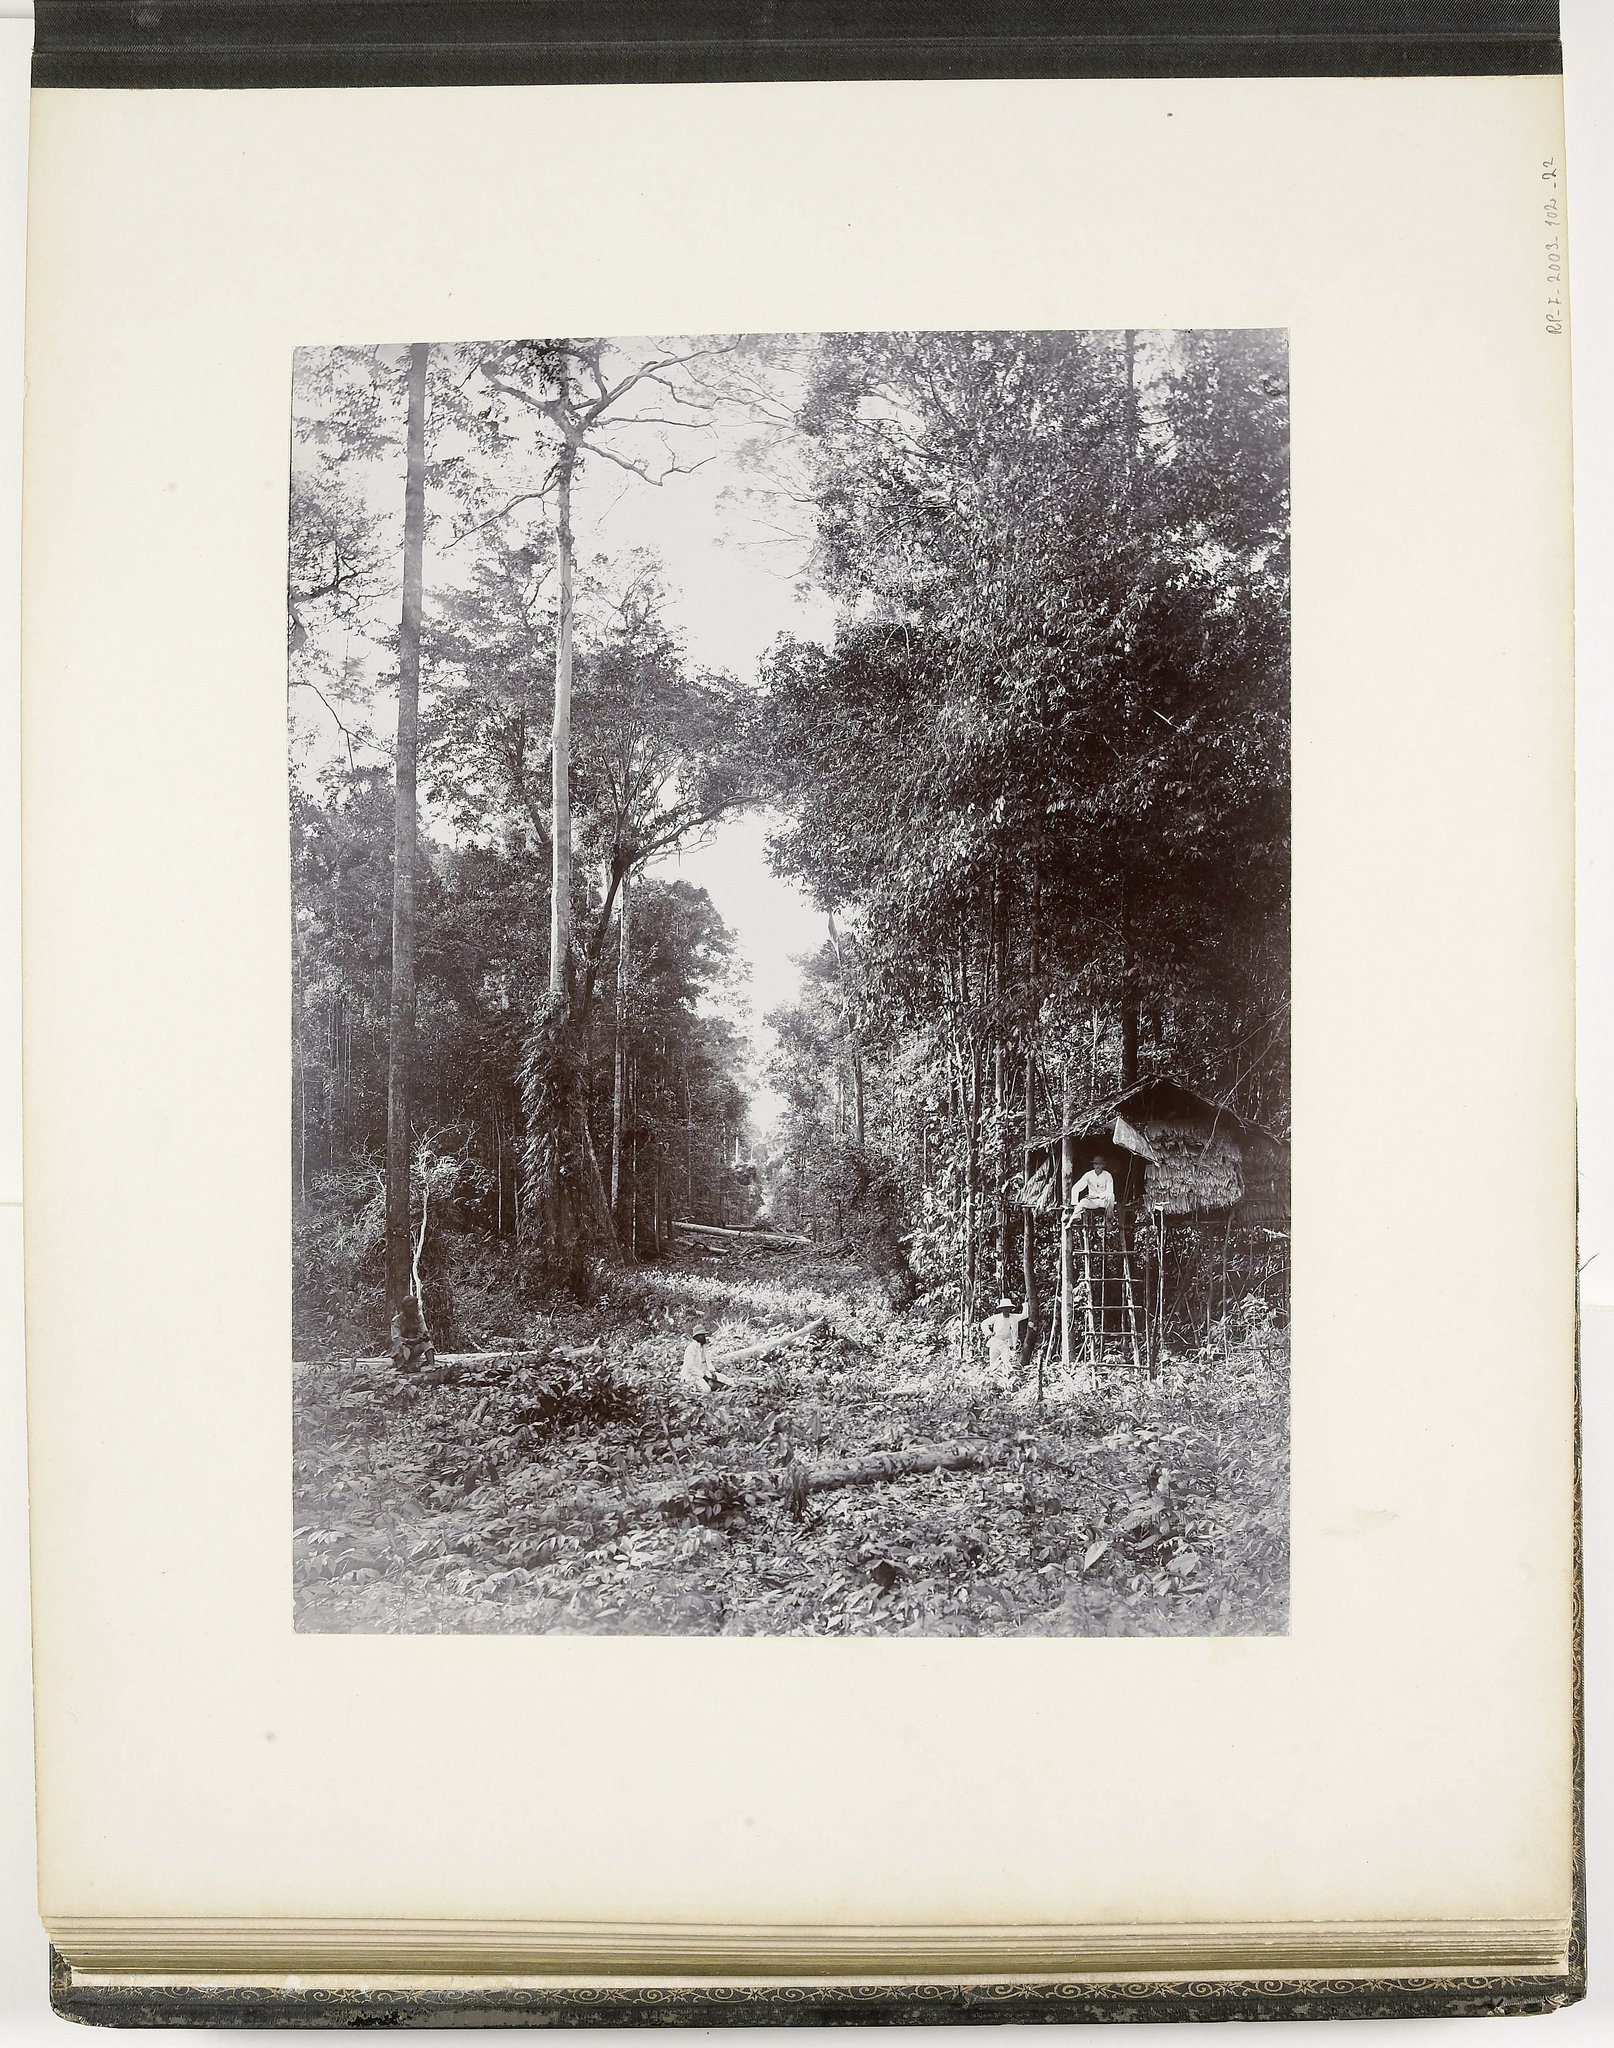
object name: photograph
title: Gezicht langs een weg door het oerwoud, Sumatra (Weg aus dem Urwald)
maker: carl j. kleingrothe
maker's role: fotograaf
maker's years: 1864-1925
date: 1885-1900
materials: photographic support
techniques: collodion silver print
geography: deli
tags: sumatra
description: Het kappen van bomen voor de aanleg van een weg door het woud, waarschijnlijk op een onderneming in Deli. Onderdeel van het Sumatra fotoalbum van Paul en Lucie Sandel uit 1900.